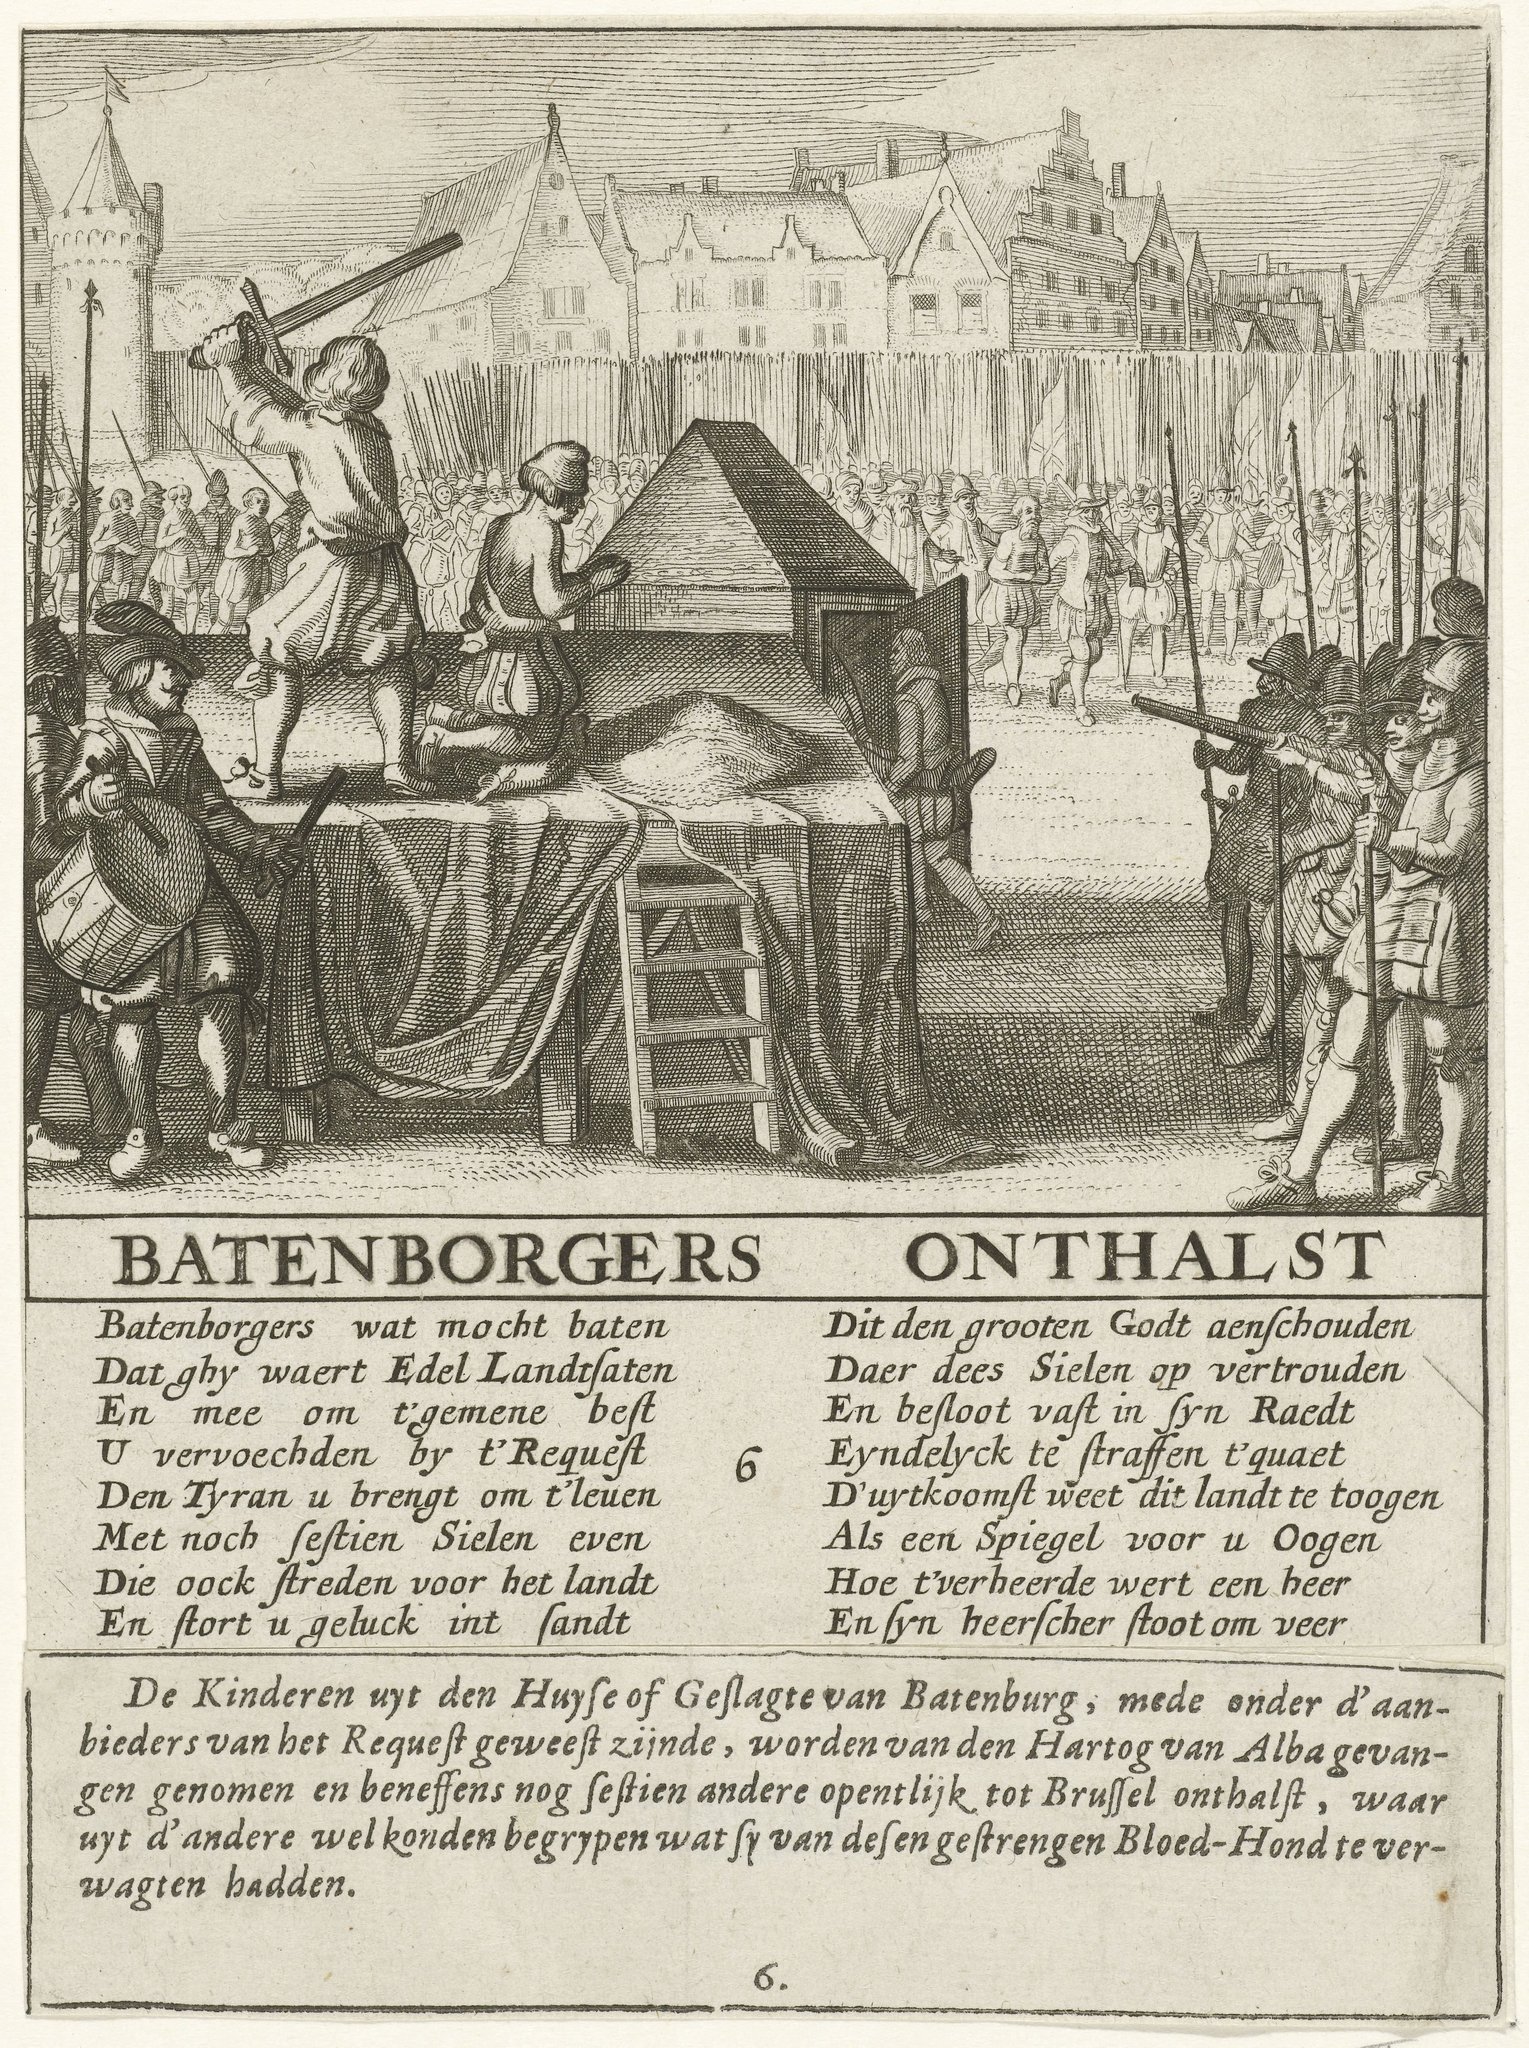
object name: history print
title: De Spaensche Tiranye gheschiet in Nederlant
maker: Anonymous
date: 1618-1624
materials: paper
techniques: etching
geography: northern netherlands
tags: fernando álvarez de toledo (3rd duke of alba), brussels, violent death by beheading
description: Illustratie voor een (onbekende) uitgave van het populaire en vaak herdrukte werk getiteld: De Spaensche Tiranye gheschiet in Nederlant, waarschijnlijk voor het eerst ca. 1620 verschenen. Zie ook Hollstein (Dutch), vol. XXXVIII (Claes Jansz. Visscher II), p. 165, nr. 425 en een andere versie van dit werk uitgegeven in 1621 te Amsterdam bij C.L. vander Plasse, in de collectie van de Rijksmuseum Research Library, signatuur 327 K 30.